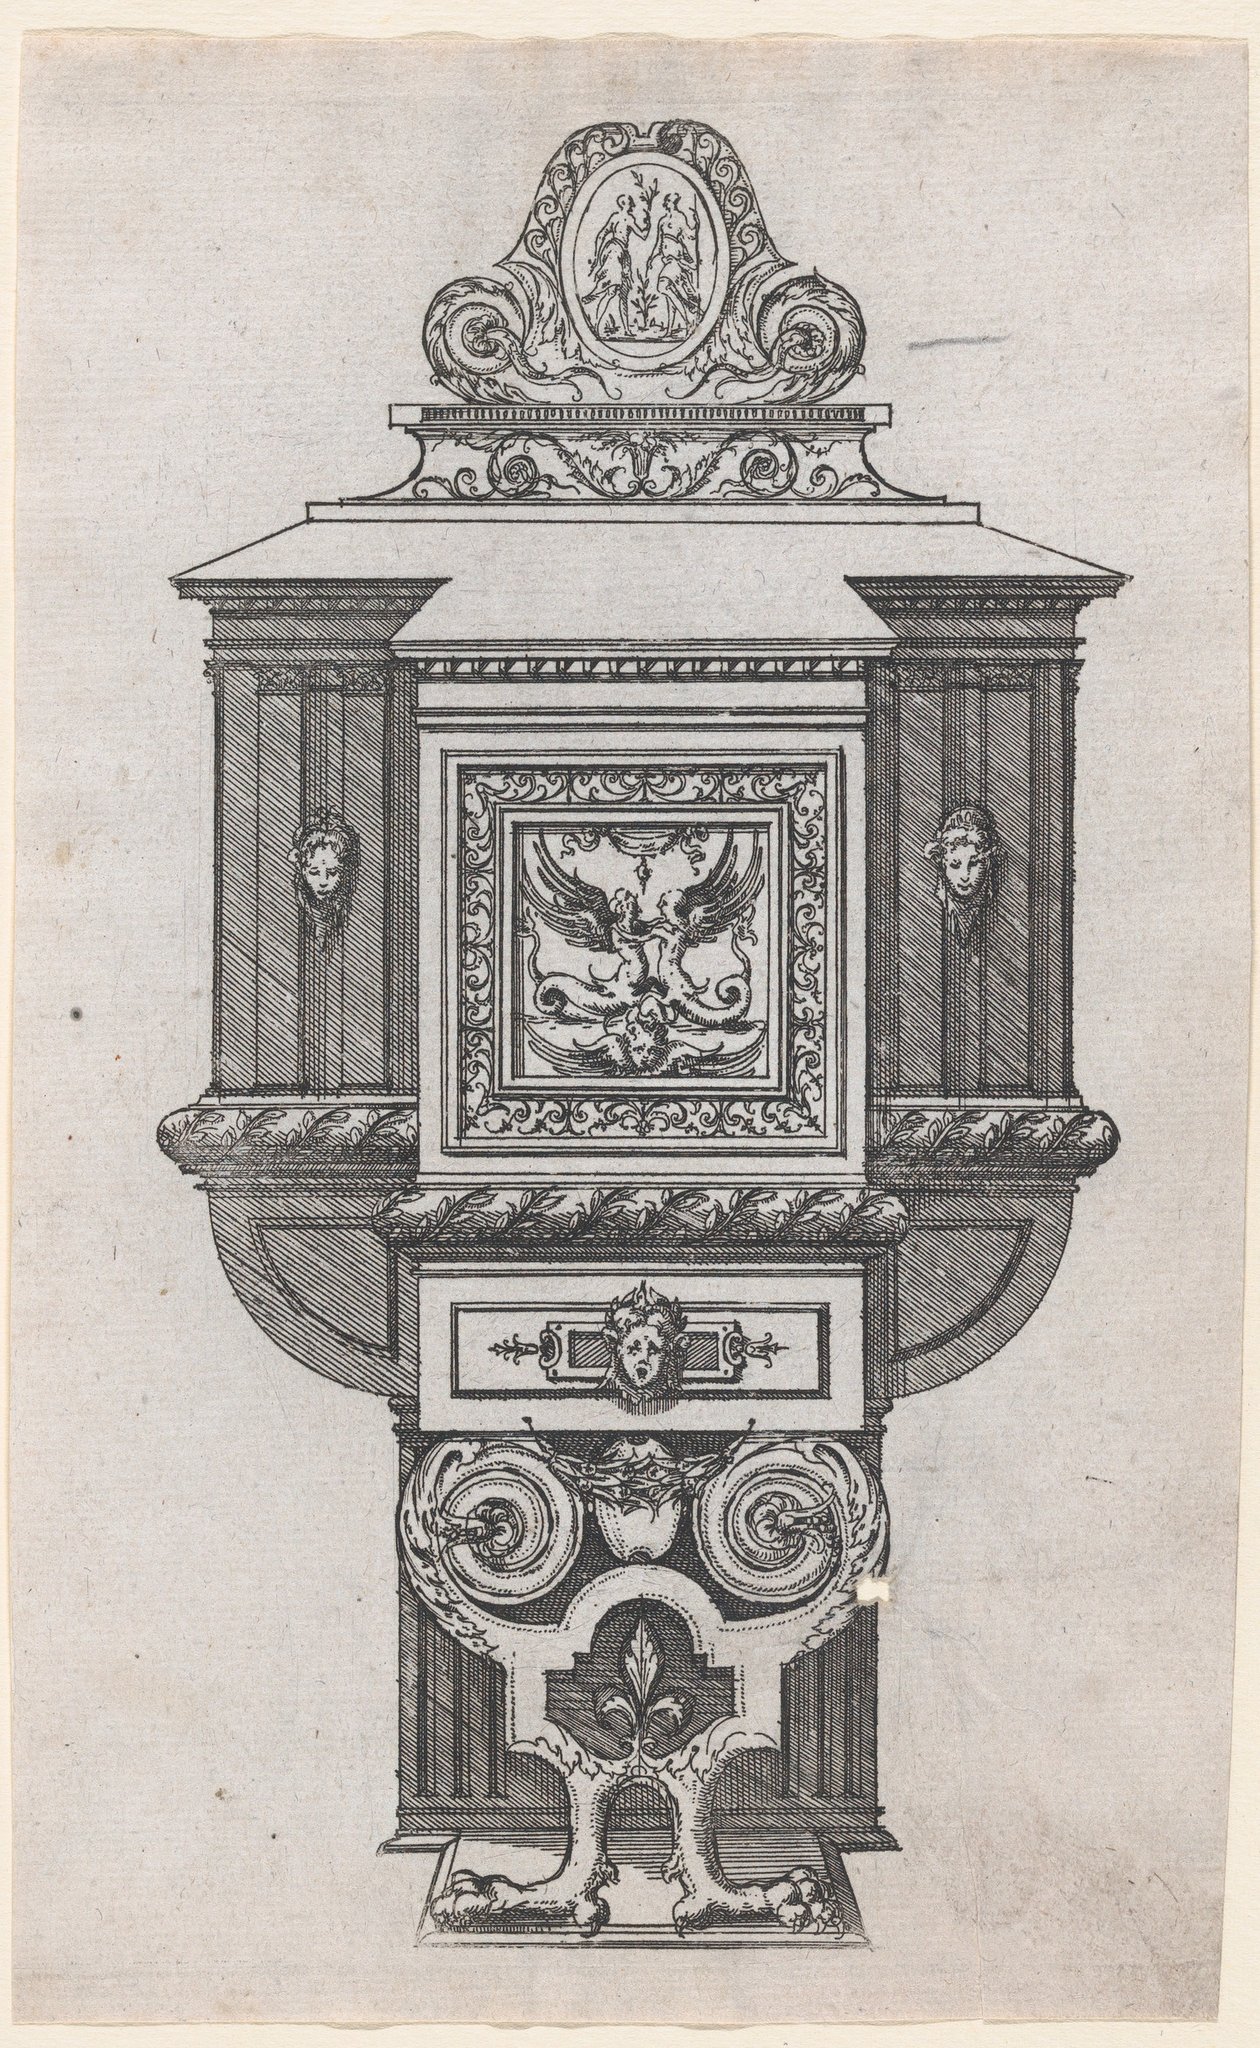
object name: print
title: Furniture Design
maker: jacques androuet du cerceau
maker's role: artist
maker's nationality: french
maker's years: 1510-1585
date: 1530-1585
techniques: etching